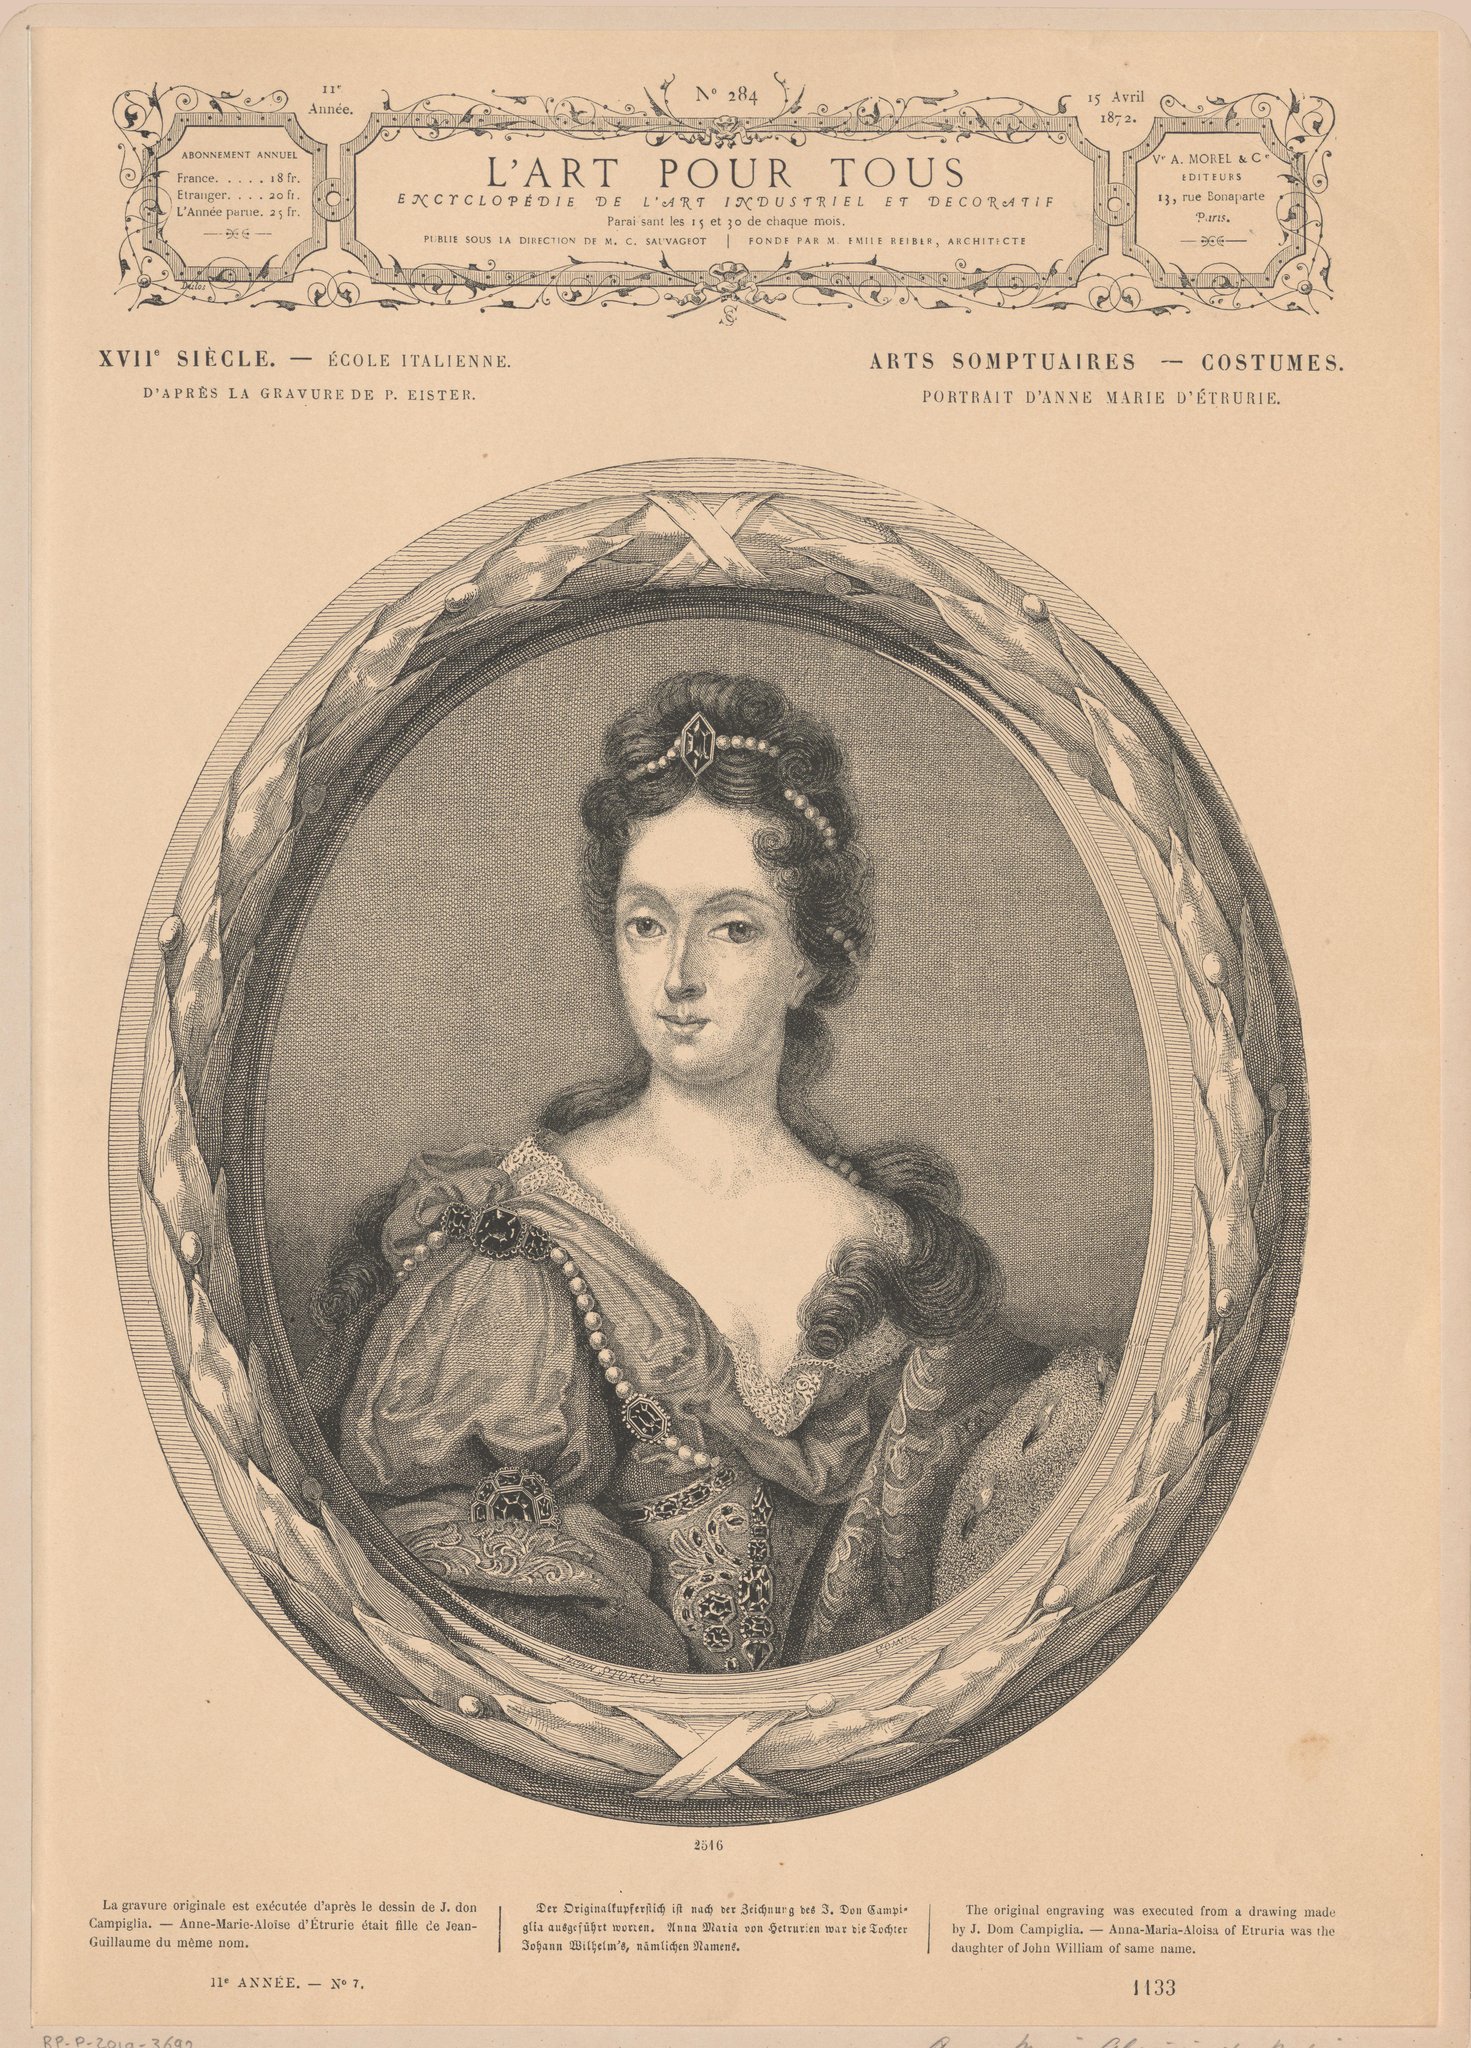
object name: photomechanical print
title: Portret van Anna Maria Luisa de' Medici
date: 1872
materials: paper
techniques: printing block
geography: paris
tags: historical persons - bb - woman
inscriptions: collector's mark: Lugt 3937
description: Prent uit: L'art pour tous (1872), nr. 284, 15 april 1872.